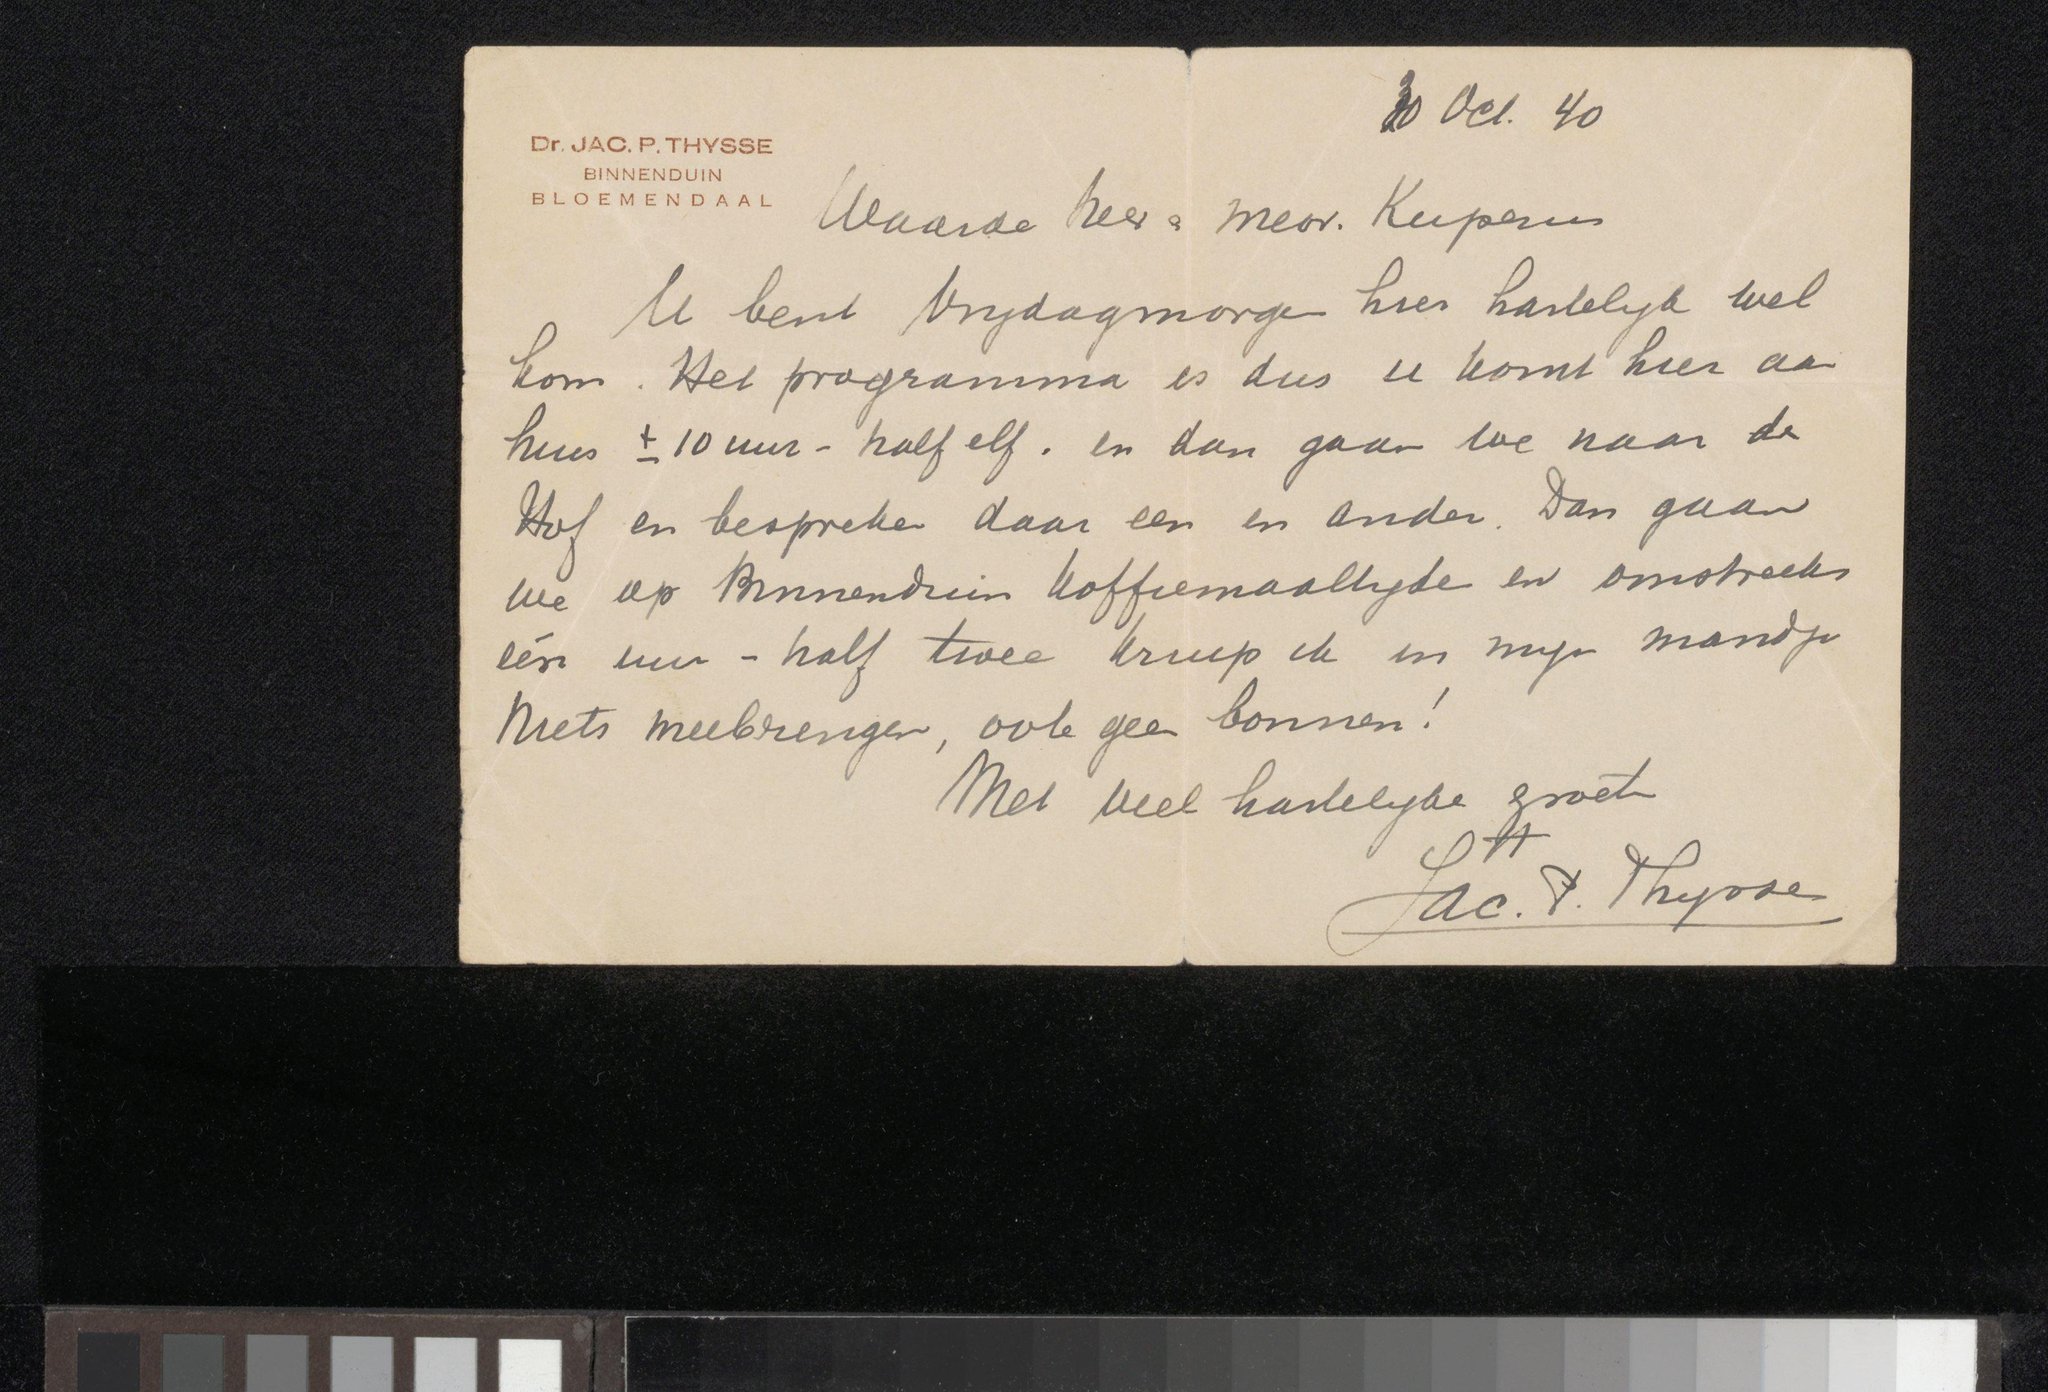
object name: letter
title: Brief aan Sjoerd Kuperus en mevrouw Kuperus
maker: jac. p. thijsse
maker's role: bioloog, onderwijzer, schrijver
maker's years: 1865-1945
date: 1940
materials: ink, paper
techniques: pen, printing, writing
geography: bloemendaal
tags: draughtsman, sjoerd kuperus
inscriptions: collector's mark: ‘RPK’